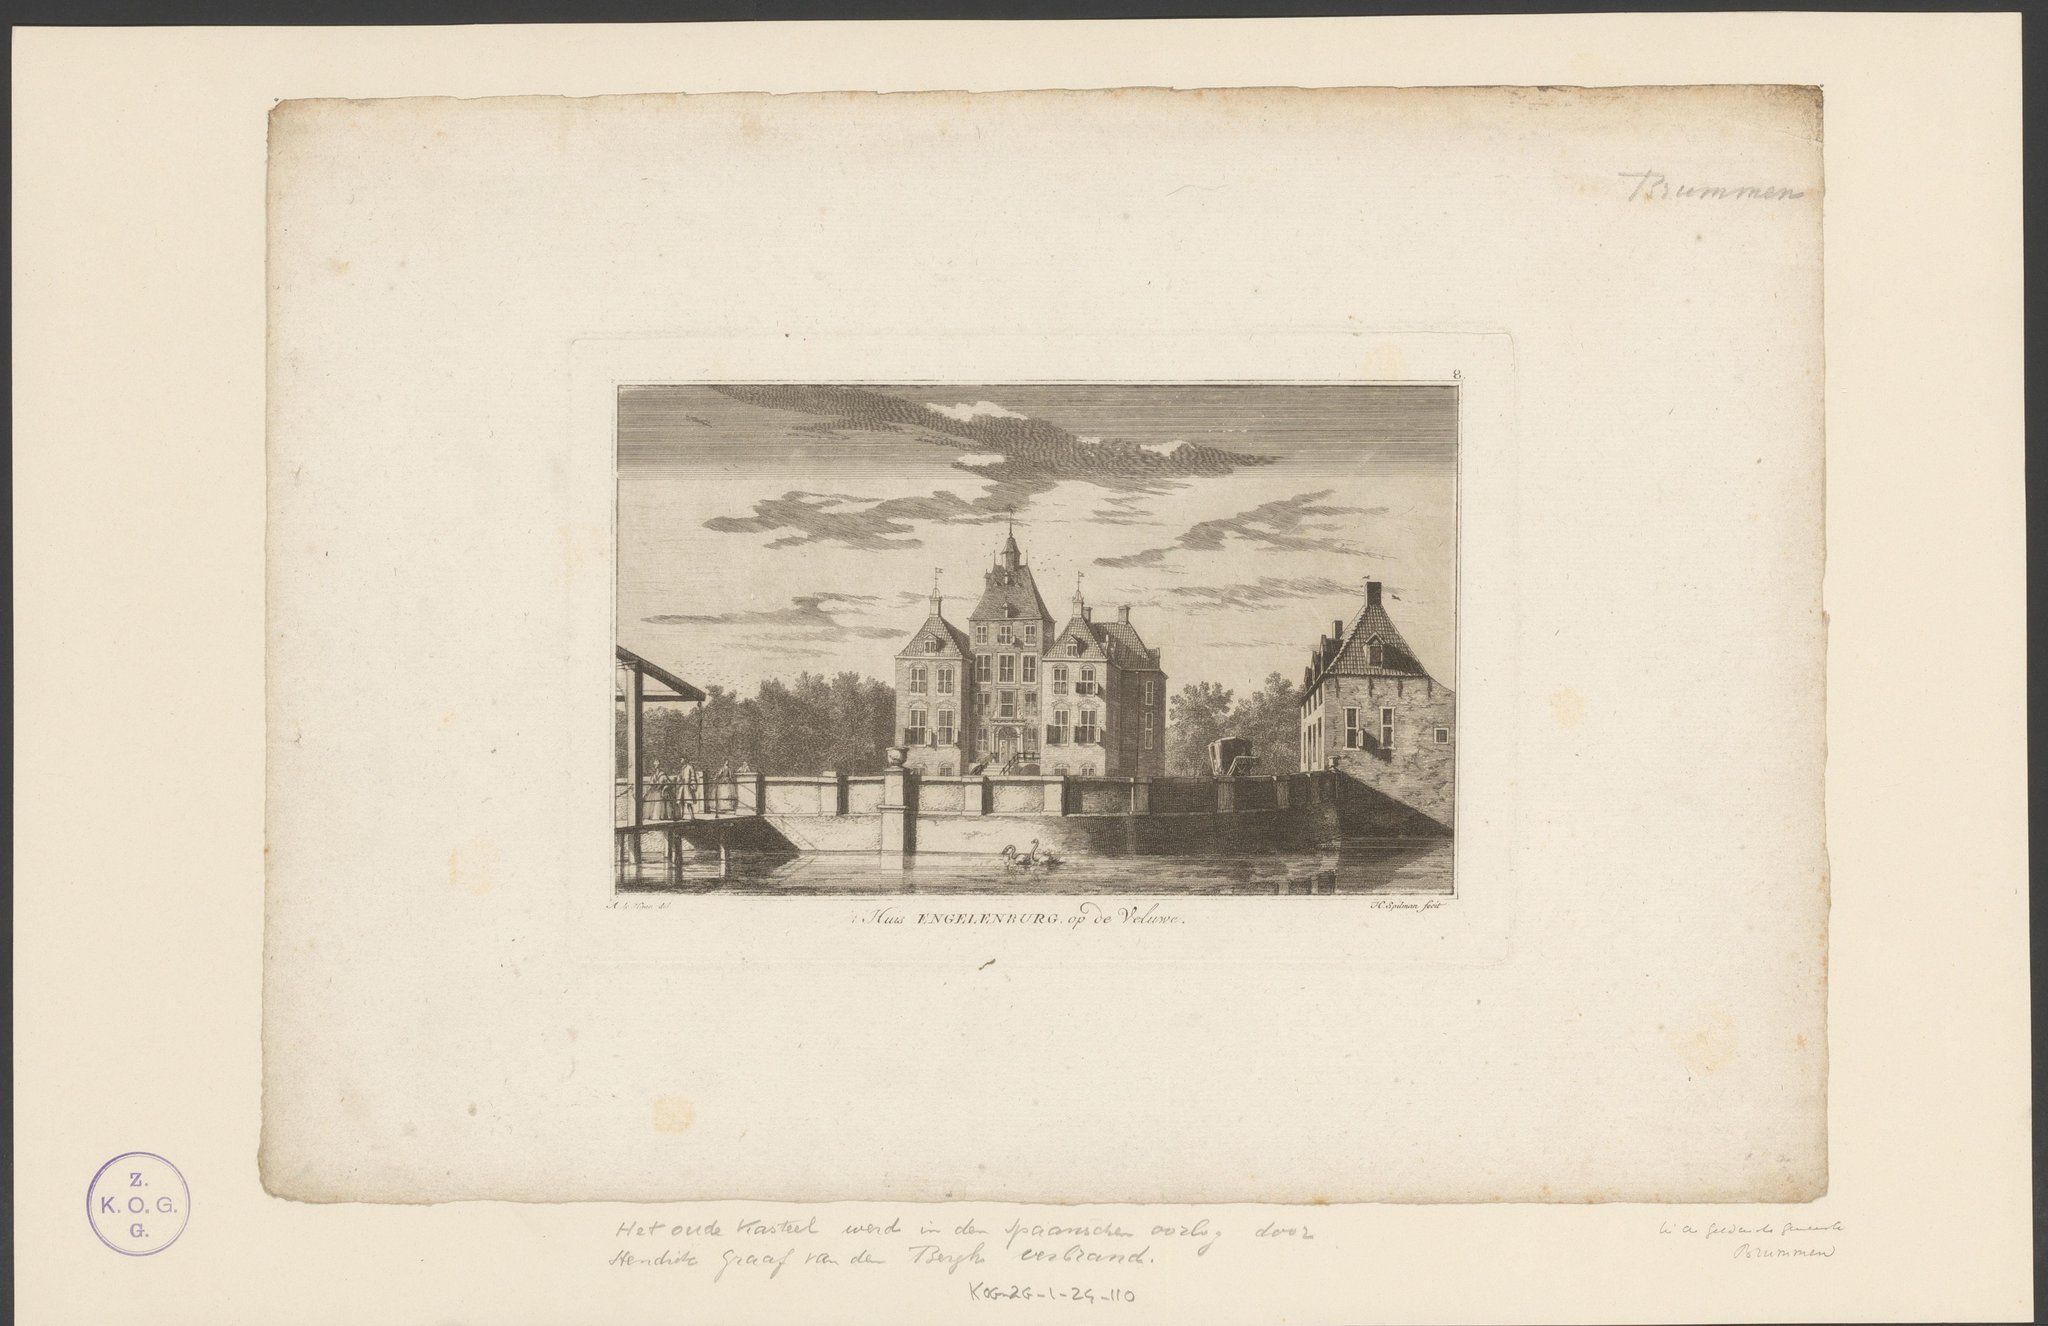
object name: print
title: Gezicht op kasteel Engelenburg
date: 1741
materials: paper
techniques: etching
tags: castle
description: Rechtsboven genummerd: 8. Onderwerpsrubrieken binnen de Atlas Zeden en Gewoonten: Zeden en Gewoonten in Engeren Zin, De Woning. Kastelen en buitenplaatsen. Over de Grenzen.